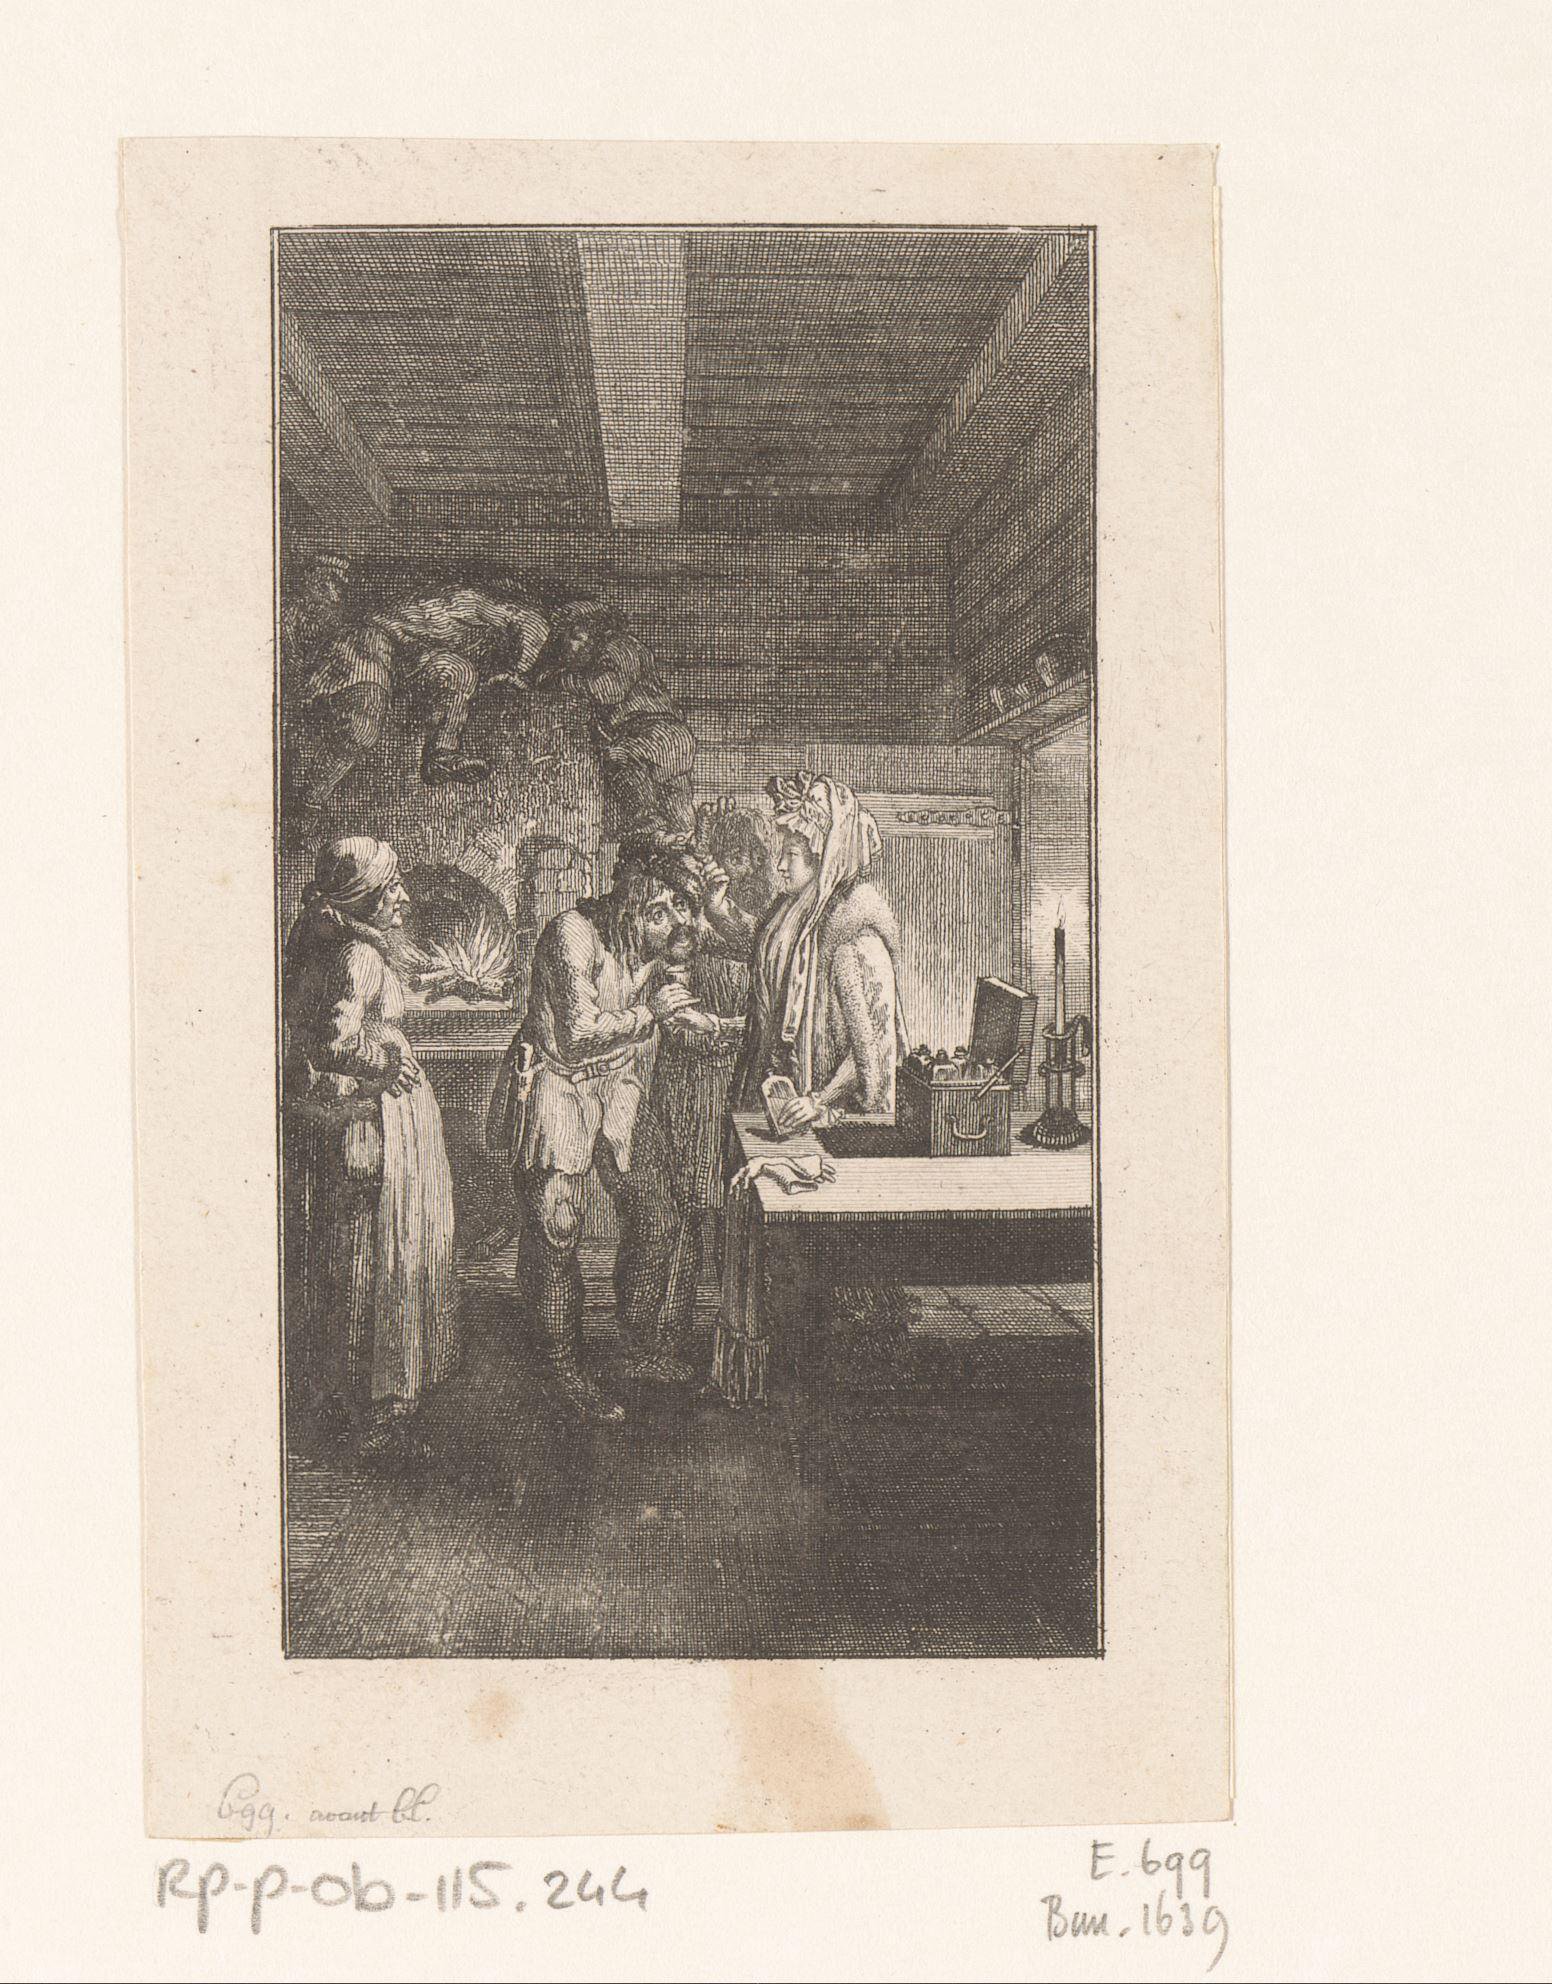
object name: print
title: Welgestelde dame overnacht in een herberg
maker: daniel nikolaus chodowiecki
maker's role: draughtsman, print maker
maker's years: 1726-1801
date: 1793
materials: paper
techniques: etching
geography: berlin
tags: literature, contrast between rich and poor, hotel, hostelry, inn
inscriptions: collector's mark: Lugt 2228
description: Prent gebruikt voor: Storch, Heinrich. Gemählde von St. Petersburg. 2 dln. Riga: Johann Friedrich Hartknoch, 1794, dl. 1.